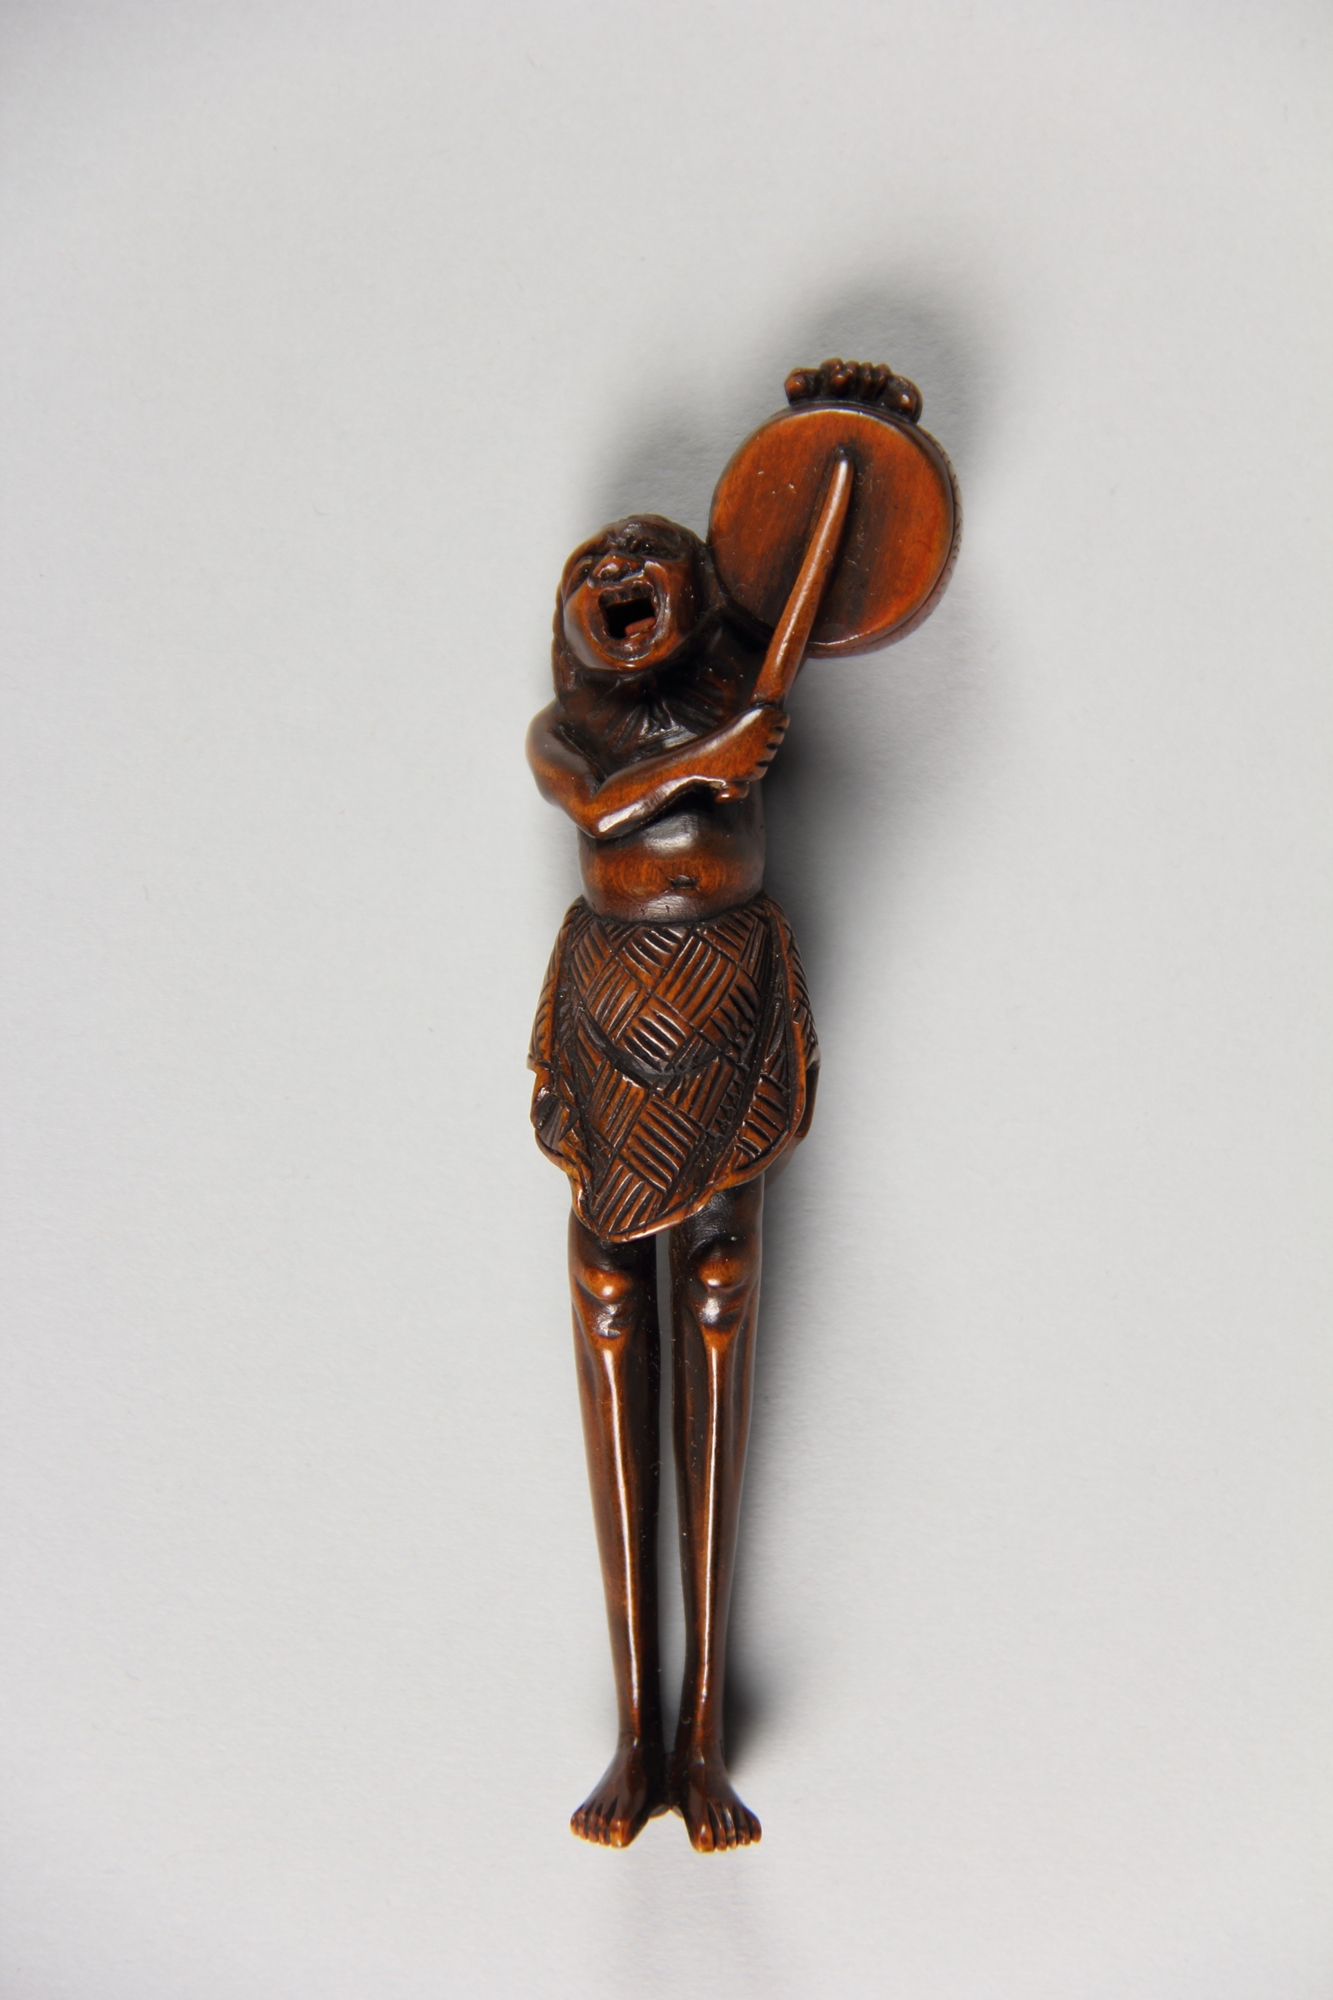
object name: netsuke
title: Netsuke of Ashinaga Beating a Drum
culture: japanese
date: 1801-1900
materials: wood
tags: human figures,drums